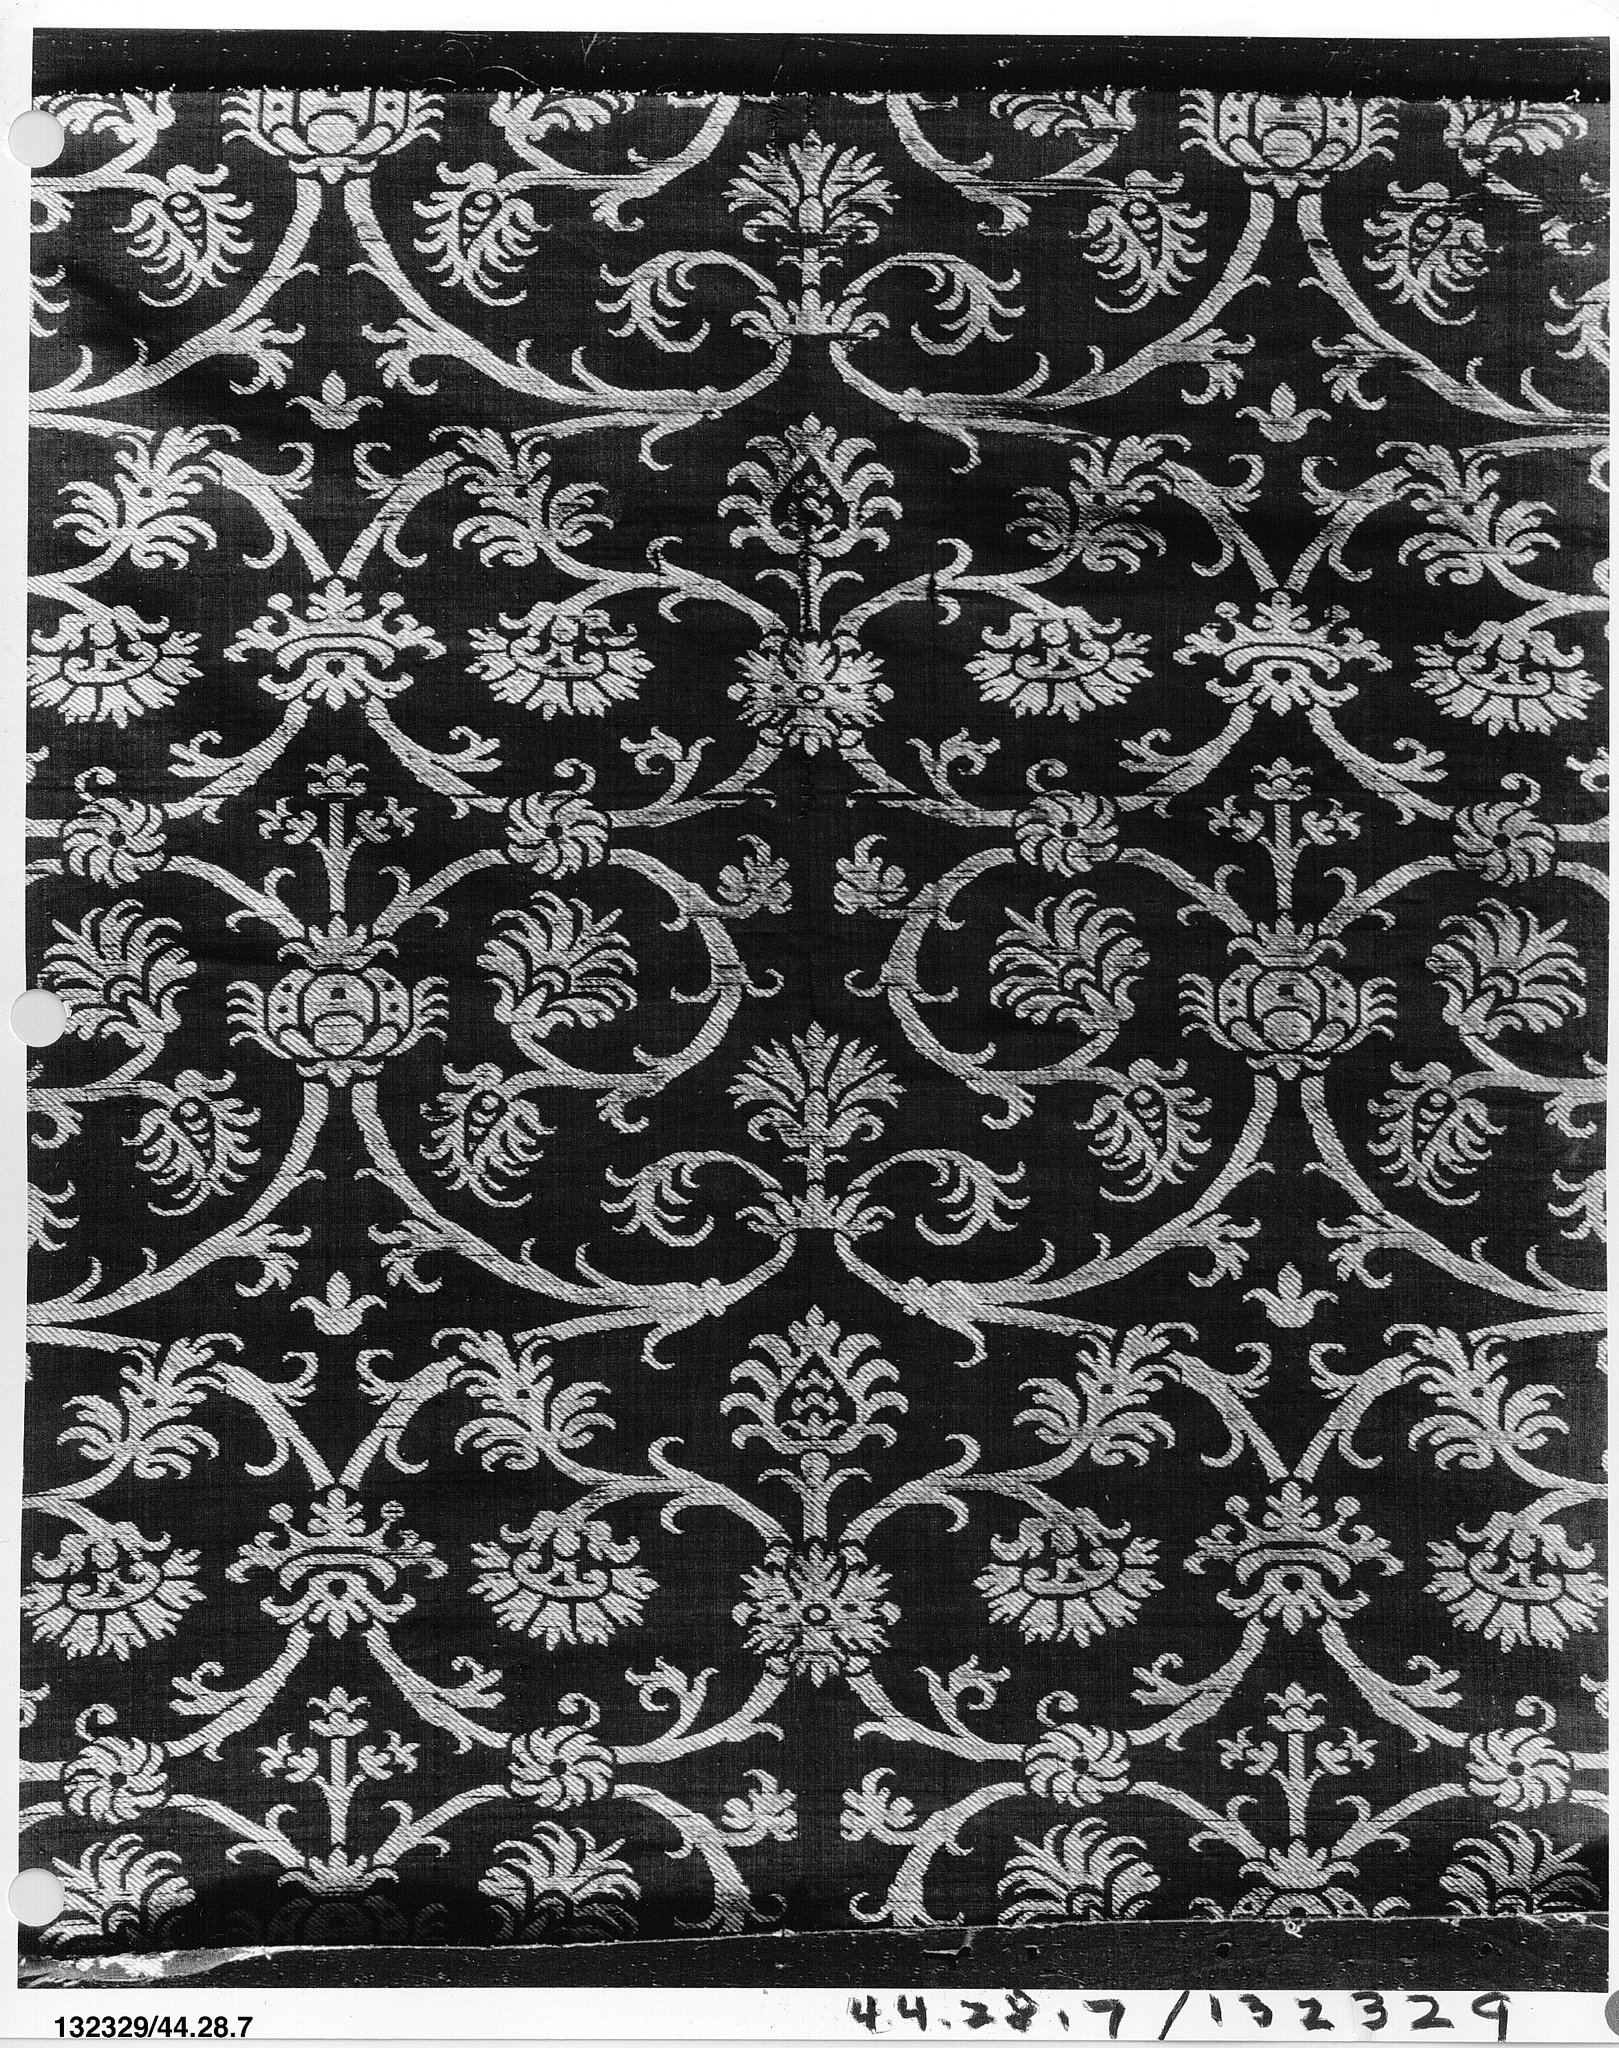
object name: piece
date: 1501-1600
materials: silk